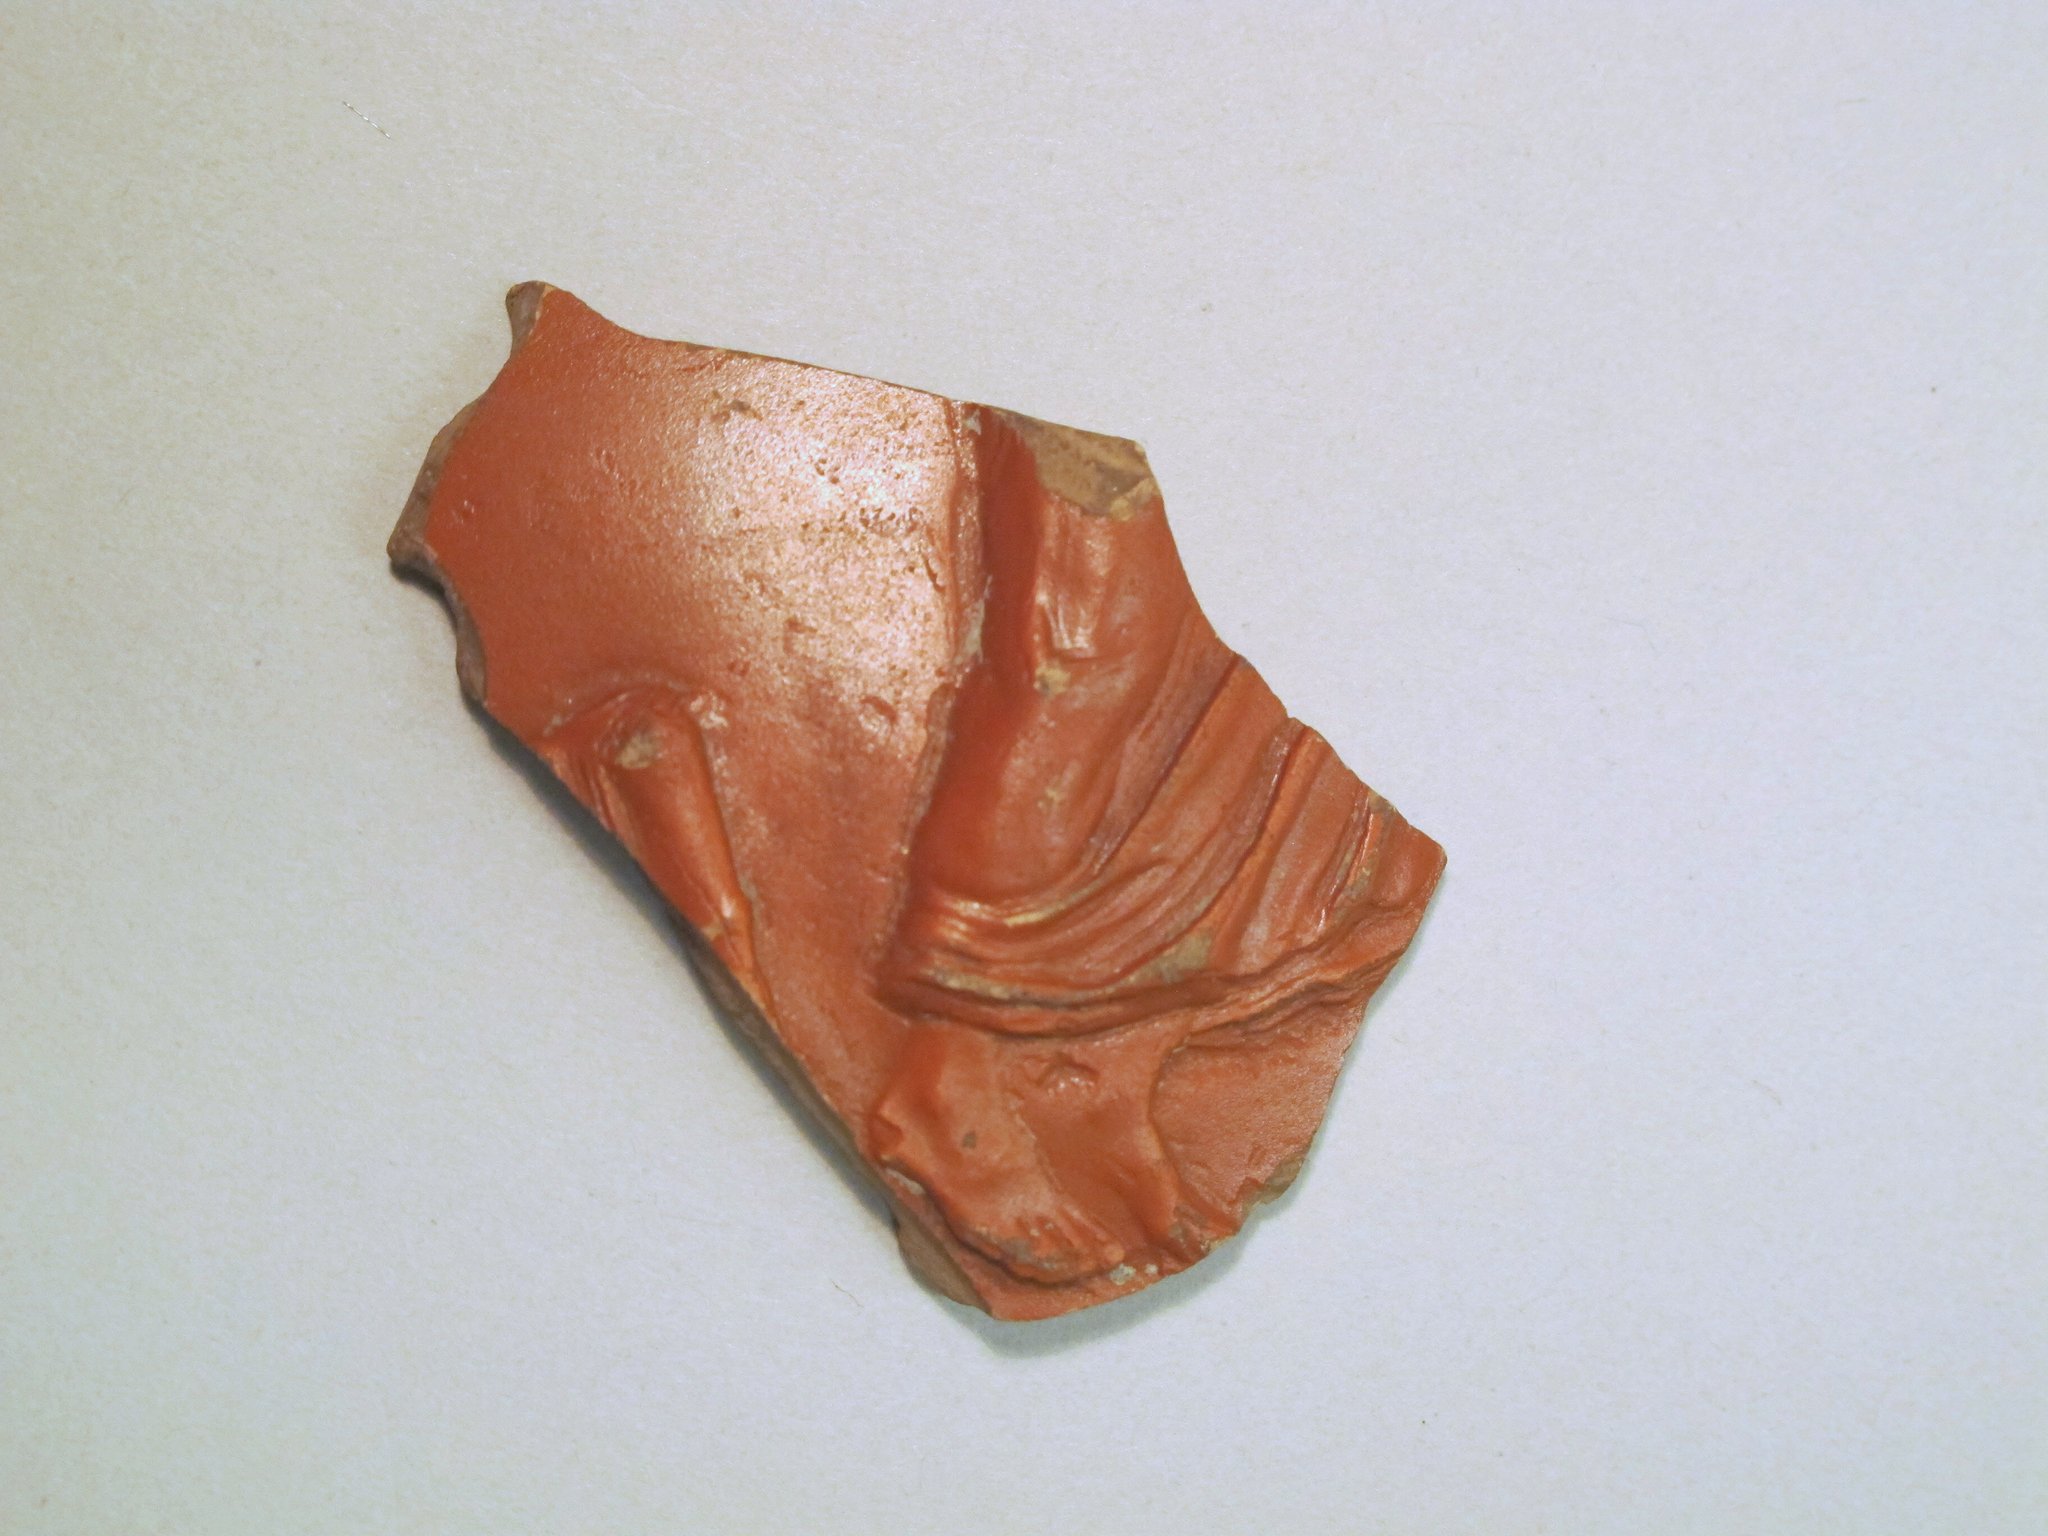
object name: vase fragment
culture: roman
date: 670 BCE-330 CE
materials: terracotta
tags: feet